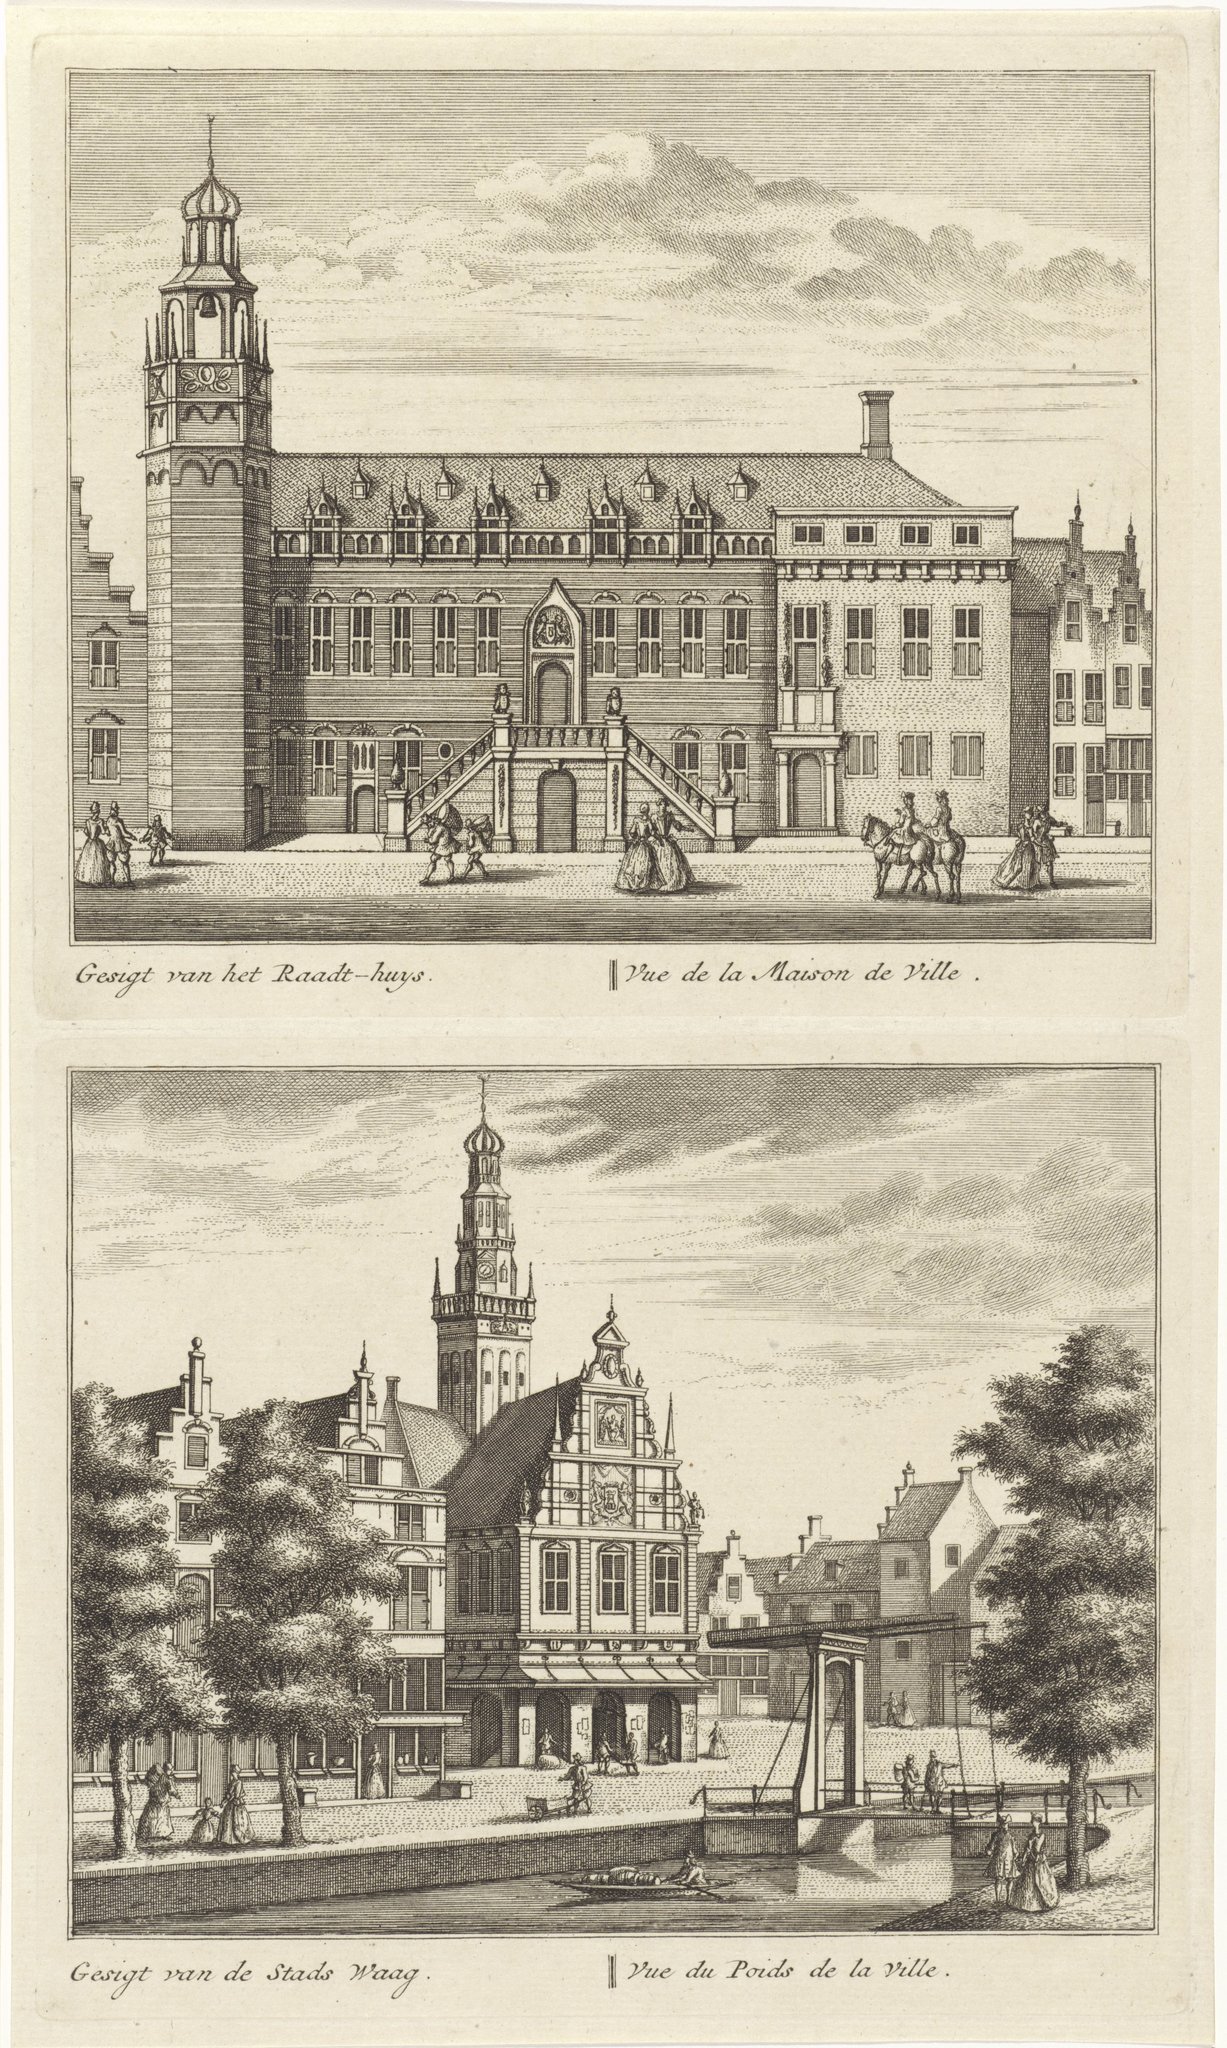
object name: print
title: Twee gezichten op Alkmaar met het stadhuis en de waag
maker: leonard schenk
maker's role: print maker, publisher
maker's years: 1696-1767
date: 1746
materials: paper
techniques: etching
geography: northern netherlands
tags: townhall, bridge, weigh-house, city-view, and landscape with man-made constructions (+ city(-scape) with figures, staffage)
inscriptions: collector's mark: Lugt 2228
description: Op de bovenste prent staan enkele figuren voor het stadhuis van Alkmaar. Op de onderste prent staat de waag van Alkmaar. Vooraan vaart een man in een roeiboot. Rechts enkele figuren op een brug over het kanaal. Onder de voorstellingen de titels in het Nederlands en Frans.